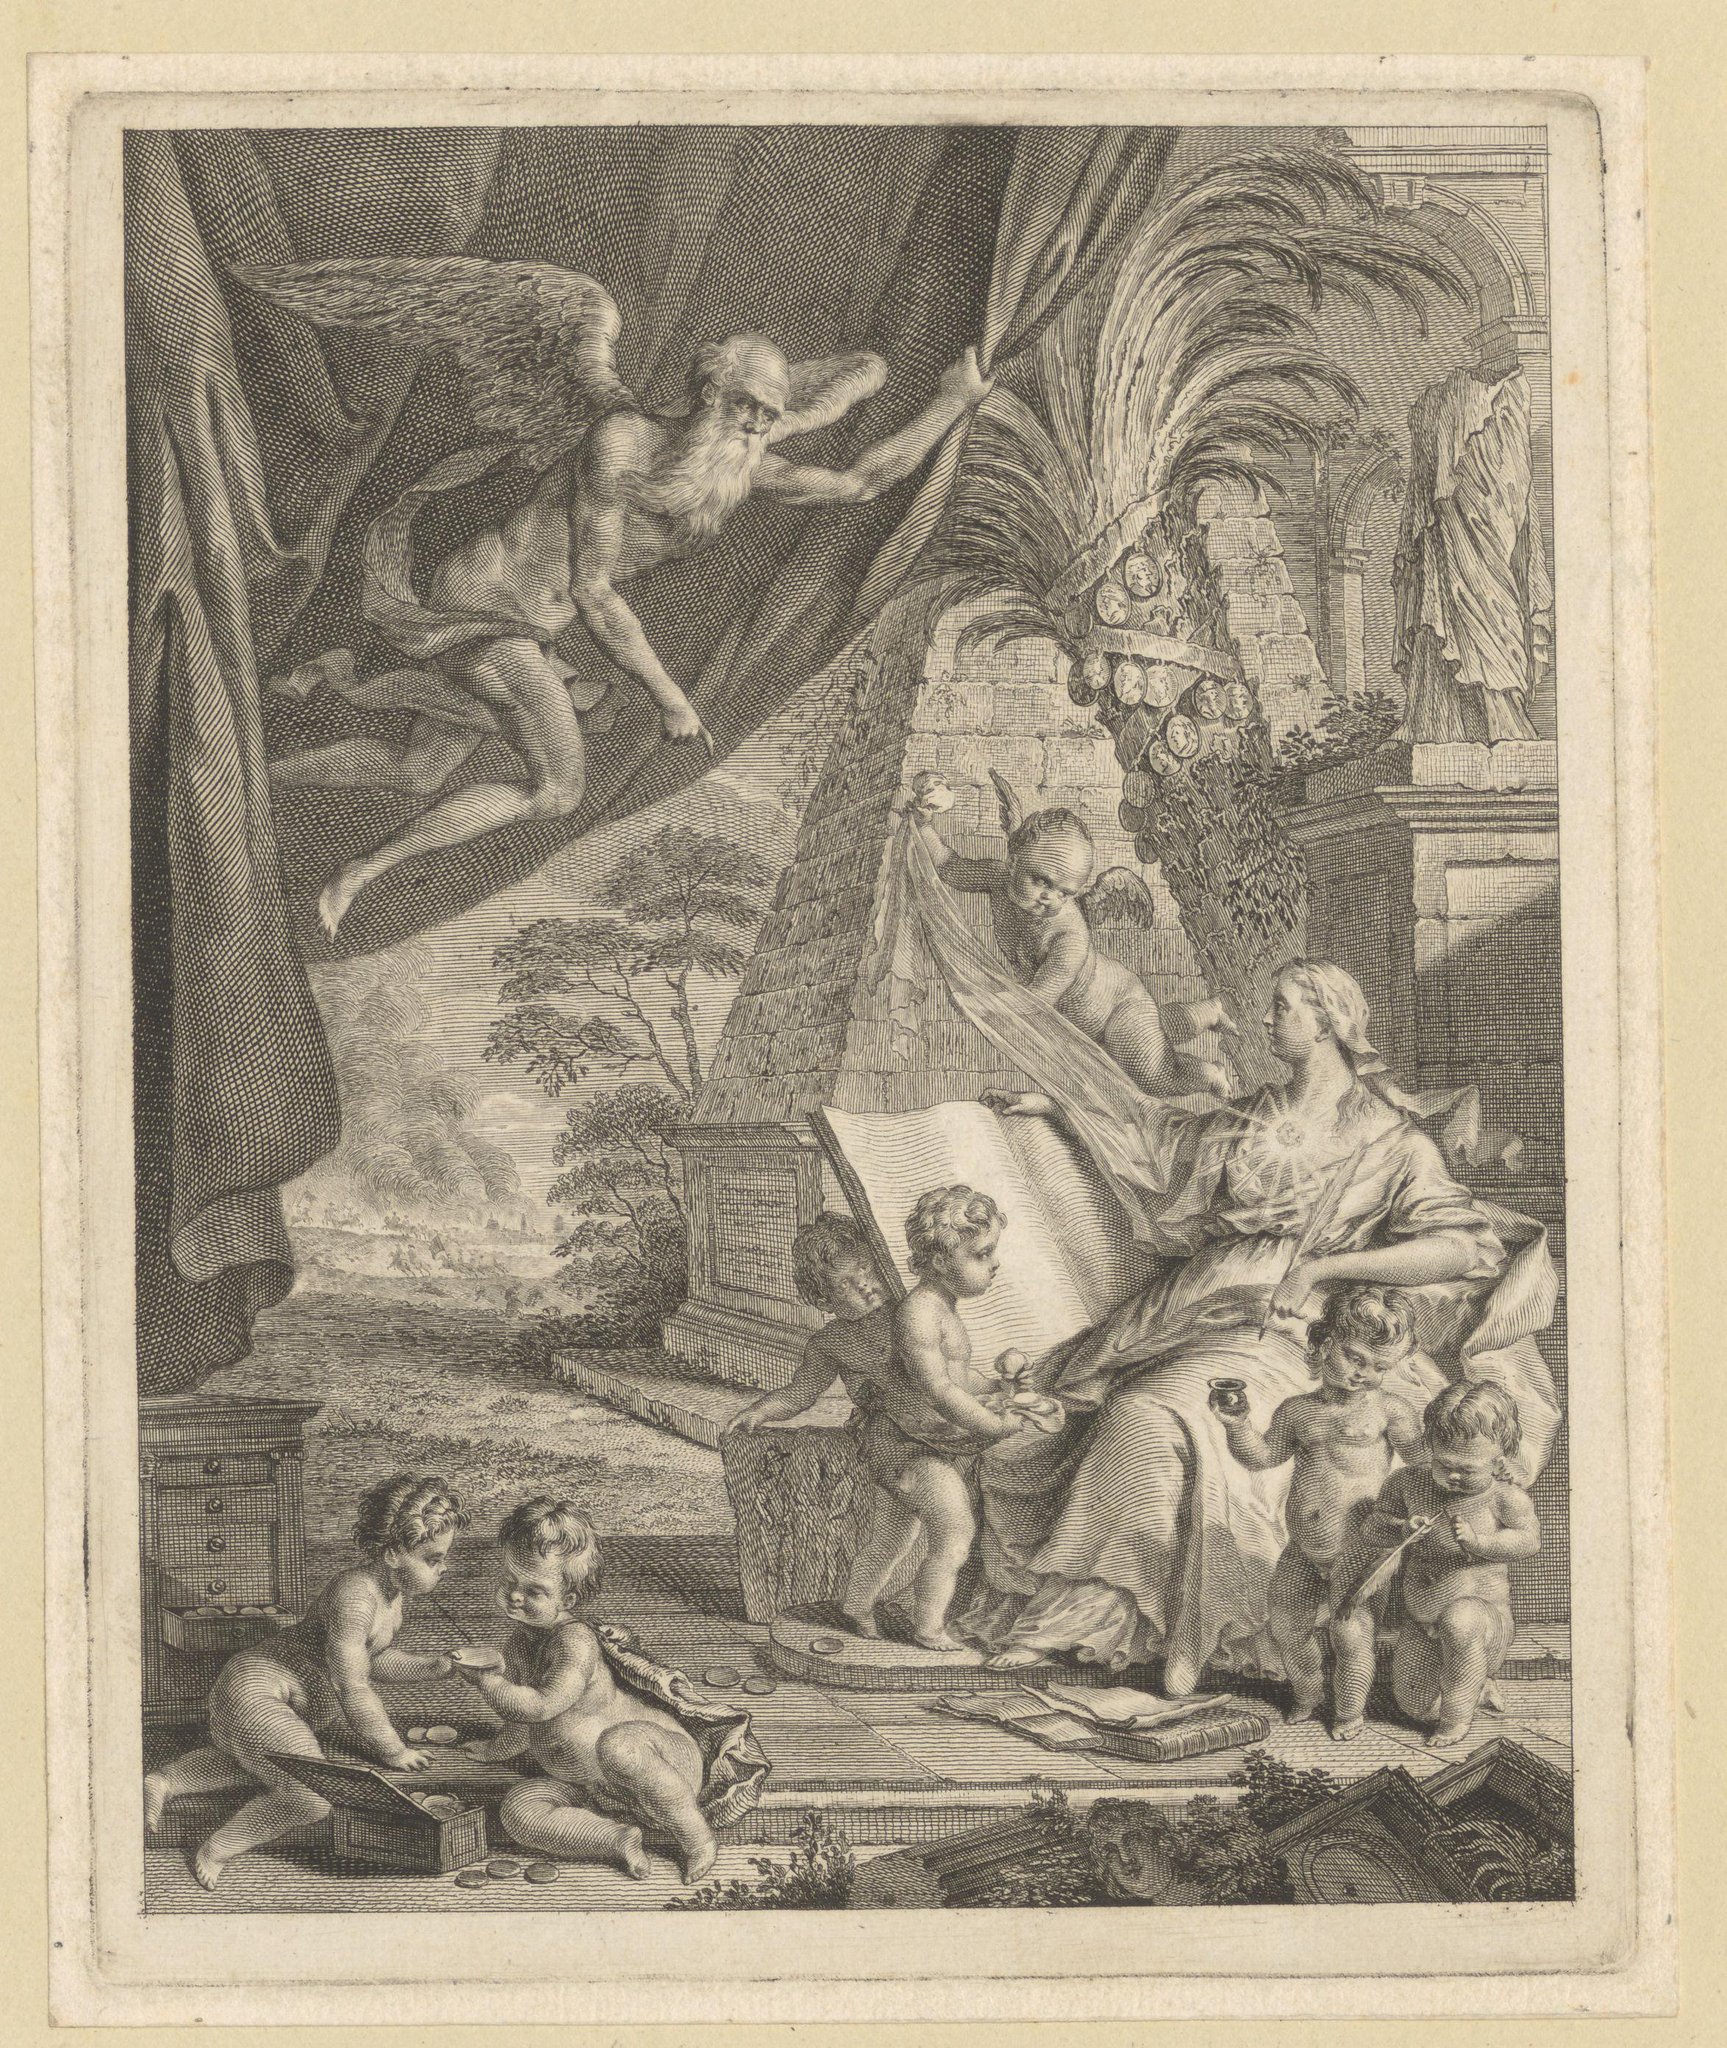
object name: book illustration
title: Allegorische voorstelling van vrouw bij groot geopend boek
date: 1751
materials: paper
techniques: etching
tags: abstract ideas and concepts (+ allegorical scene, i.e. two or more personifications involved in an action)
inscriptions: collector's mark: Lugt 240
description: Prent ook gebruikt in: Frederik de Grote. Mémoires pour servir a l'histoire de la maison de Brandebourg. Sanssouci, Frederik de Grote, 1751.